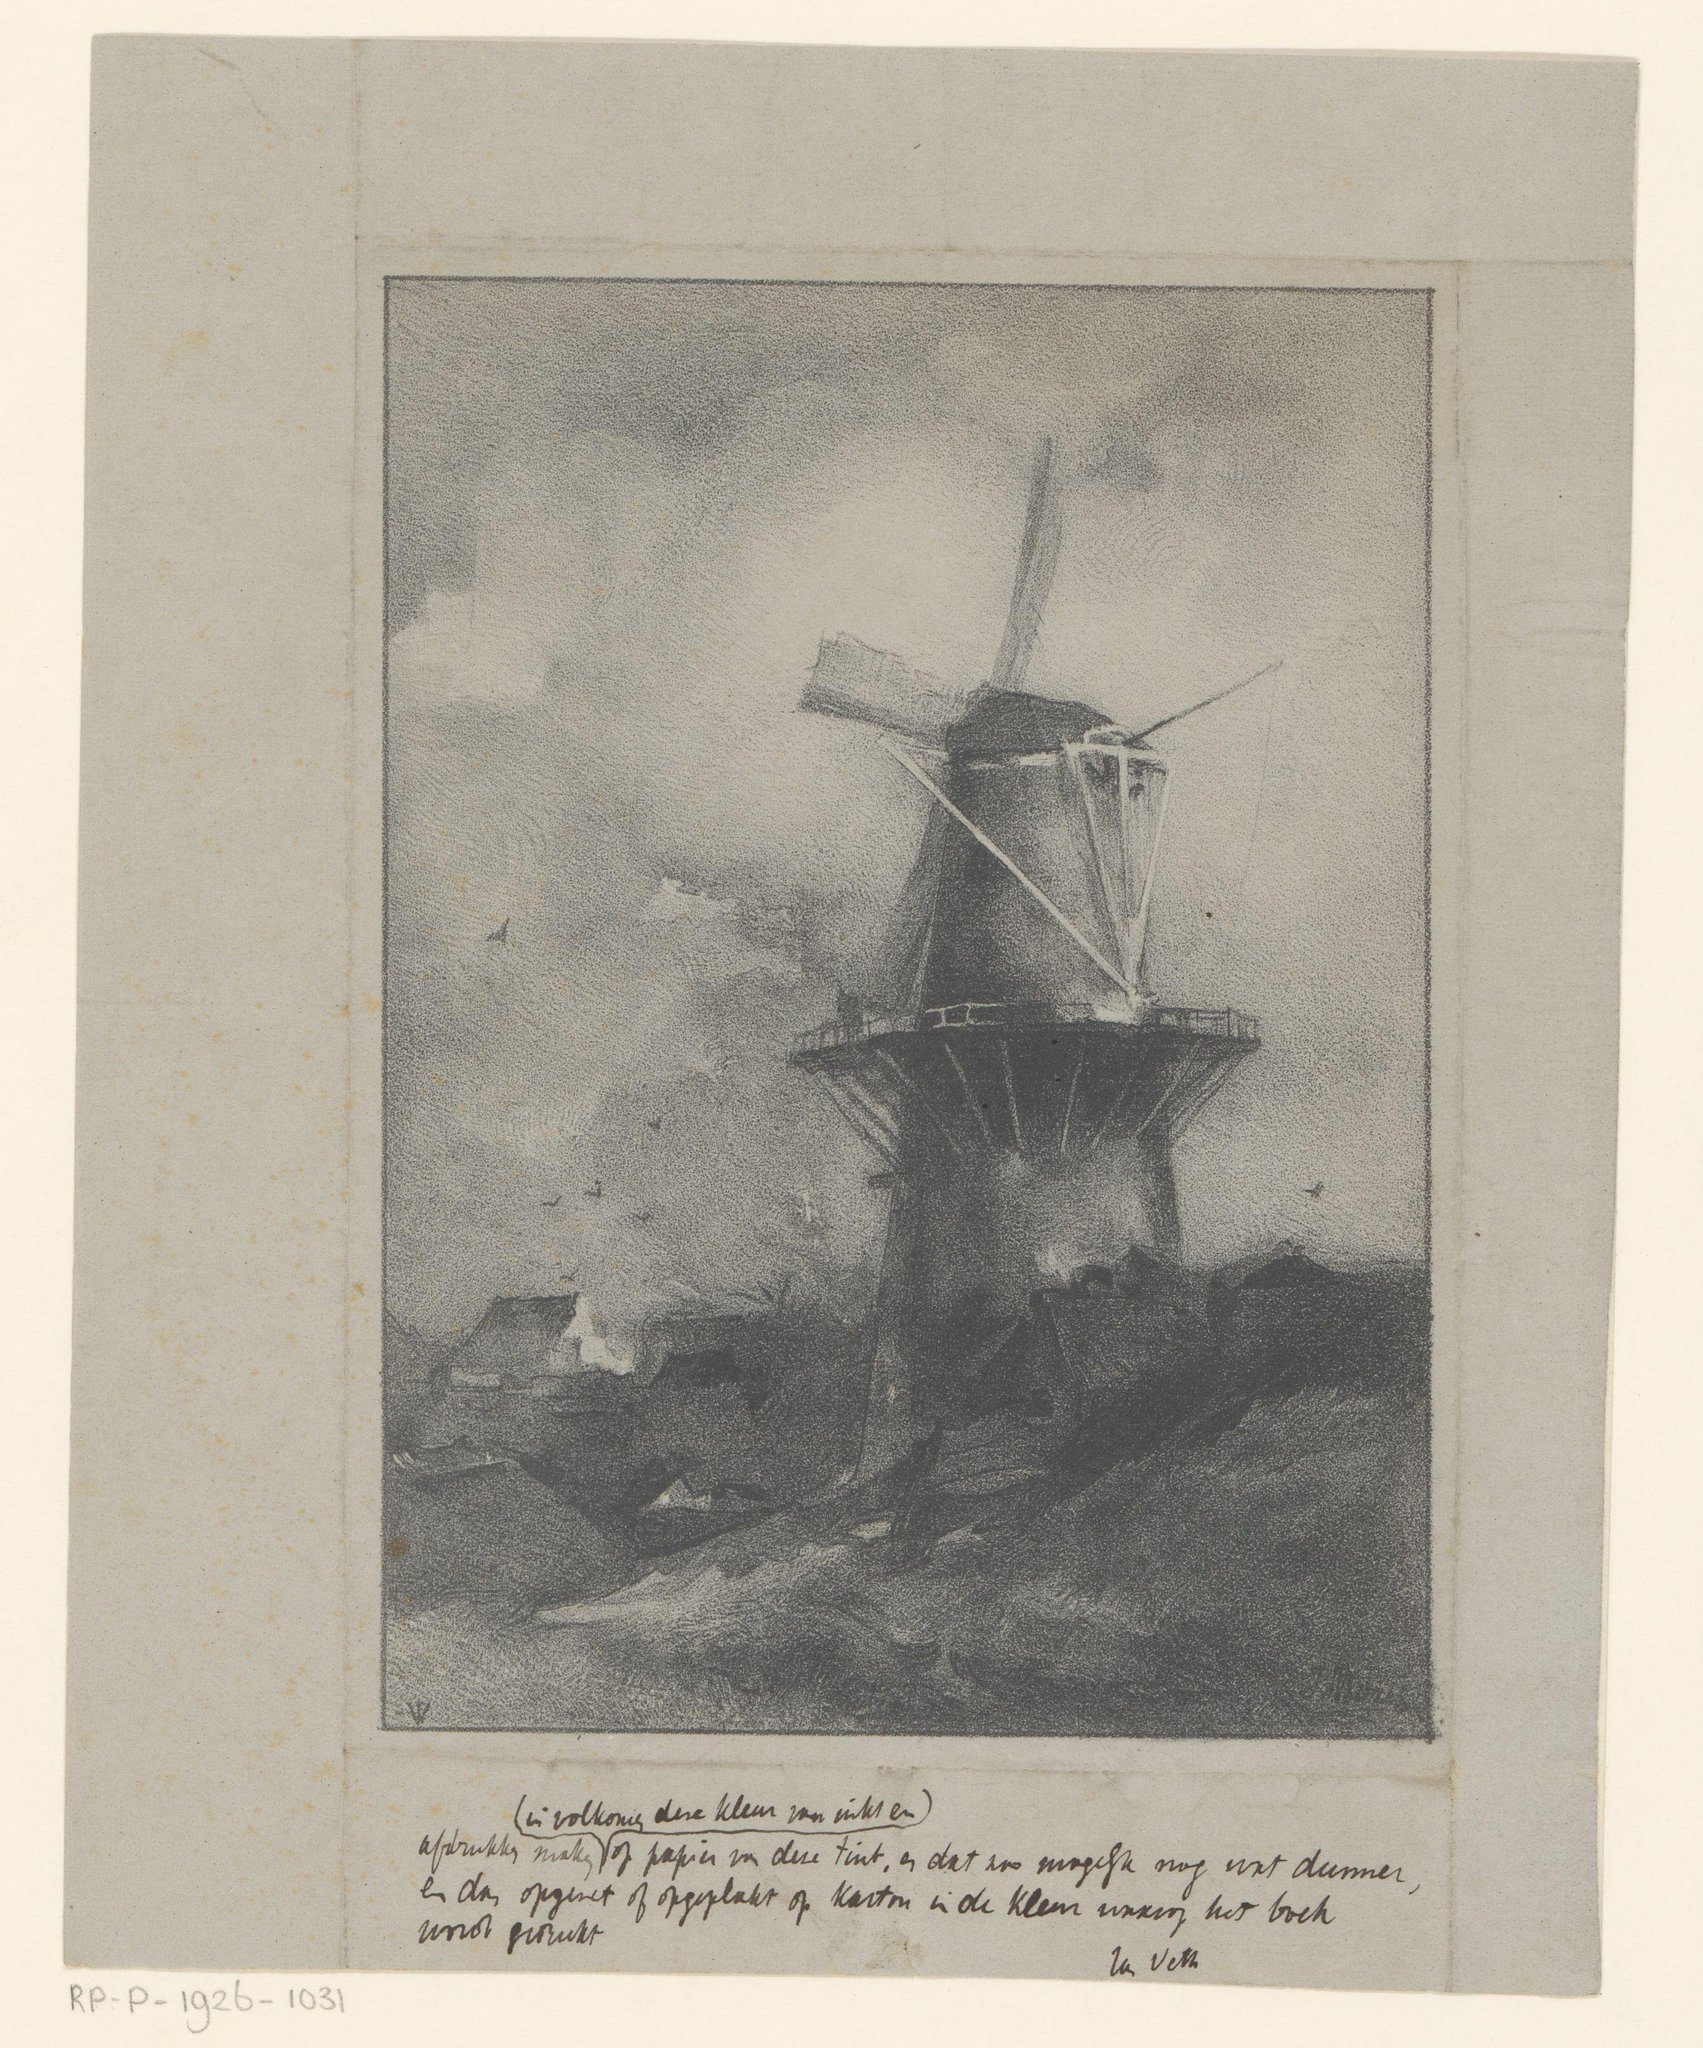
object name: print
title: Molen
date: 1880-1900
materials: paper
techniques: lithograph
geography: netherlands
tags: windmill in landscape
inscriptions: collector's mark: Lugt 2228, inscription: ‘afdrukken maken (in [...] deze kleur van inkt en) op papier van deze tint, en daar zoo mogelijk nog wat dunner, en dan opgezet of opgeplakt op karton in de kleur waarop het boek wordt gedrukt / Jan Veth’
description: Een stenen molen in een landschap met huizen in de achtergrond.